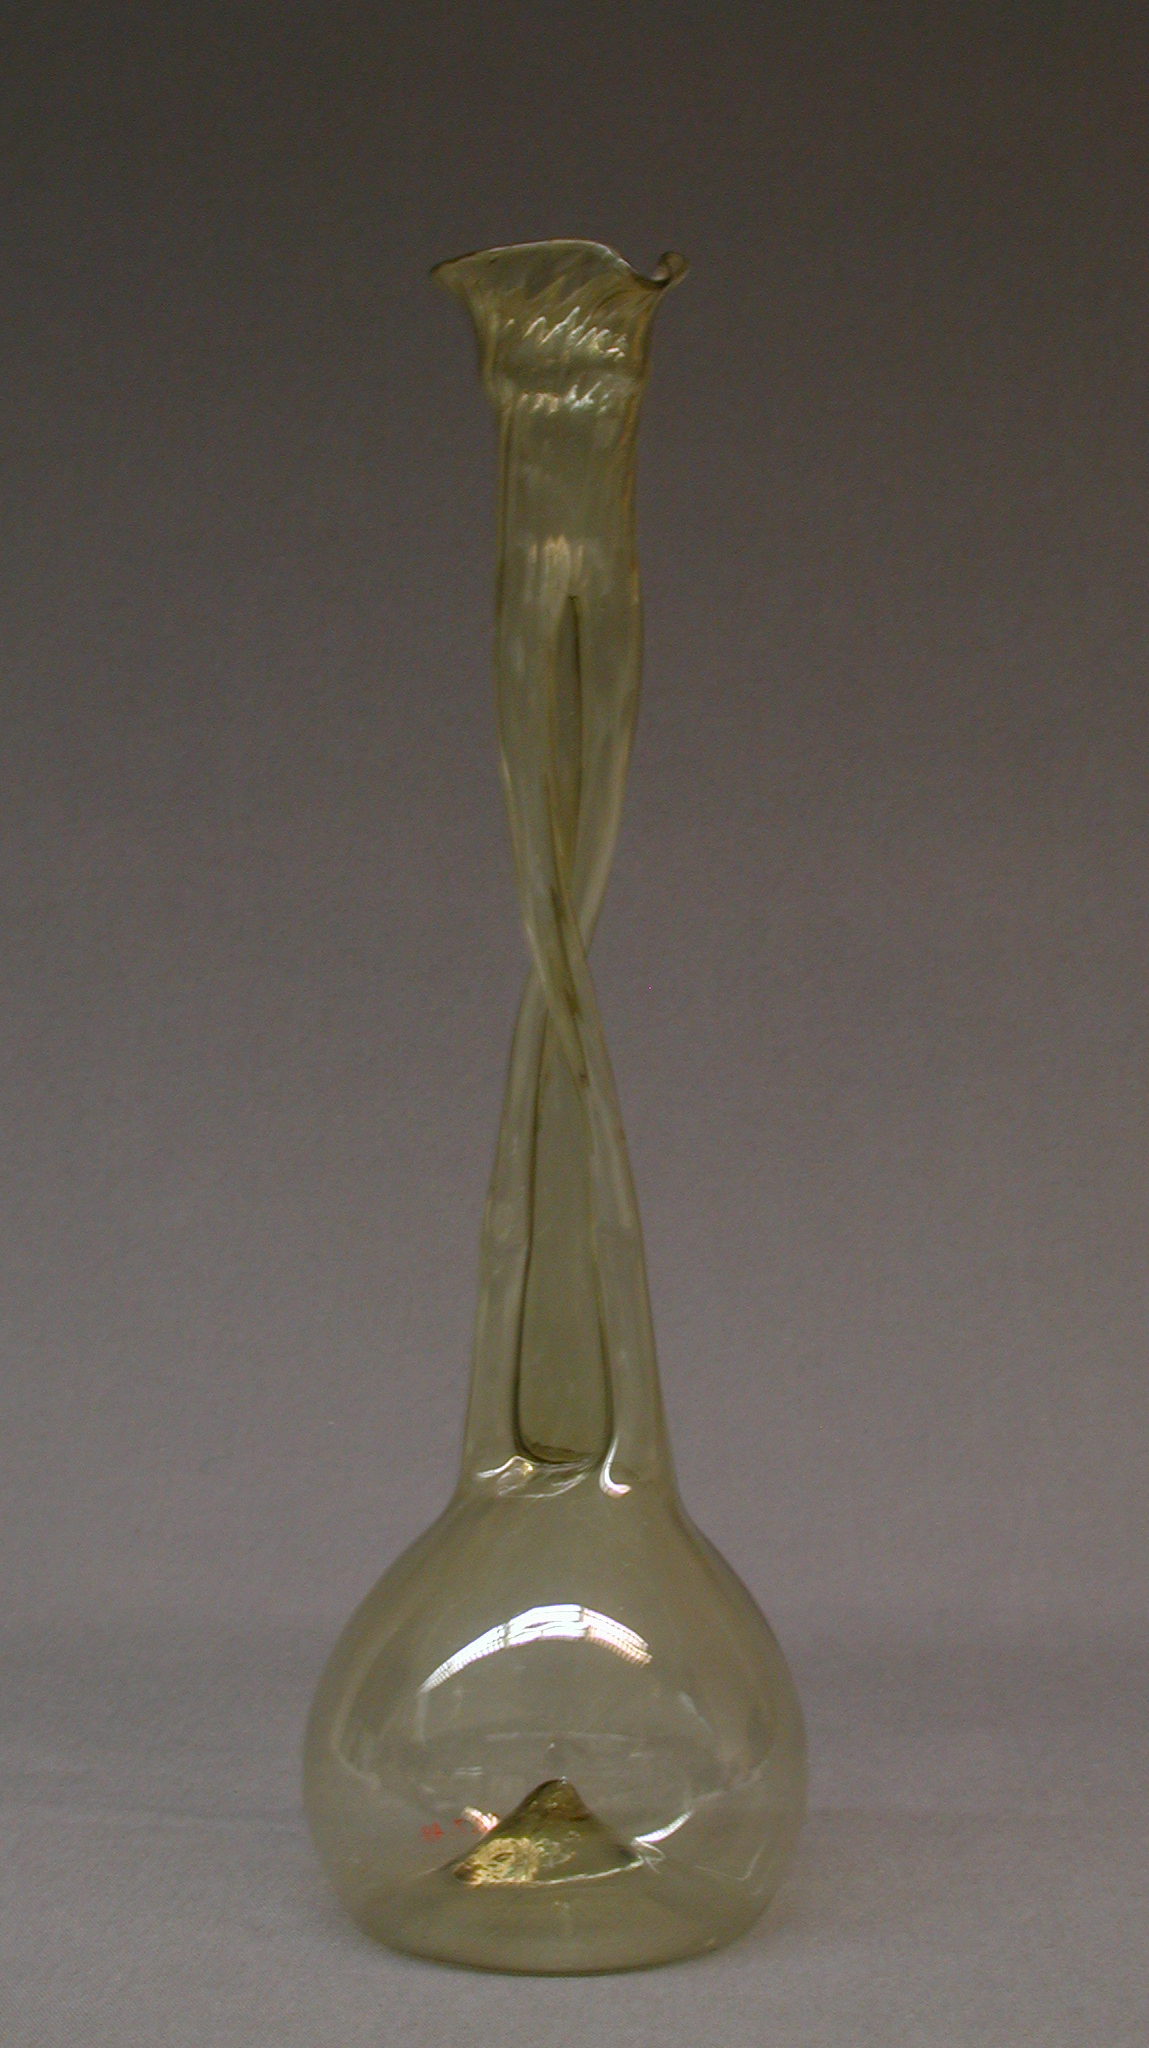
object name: flask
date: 1601-1700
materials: glass